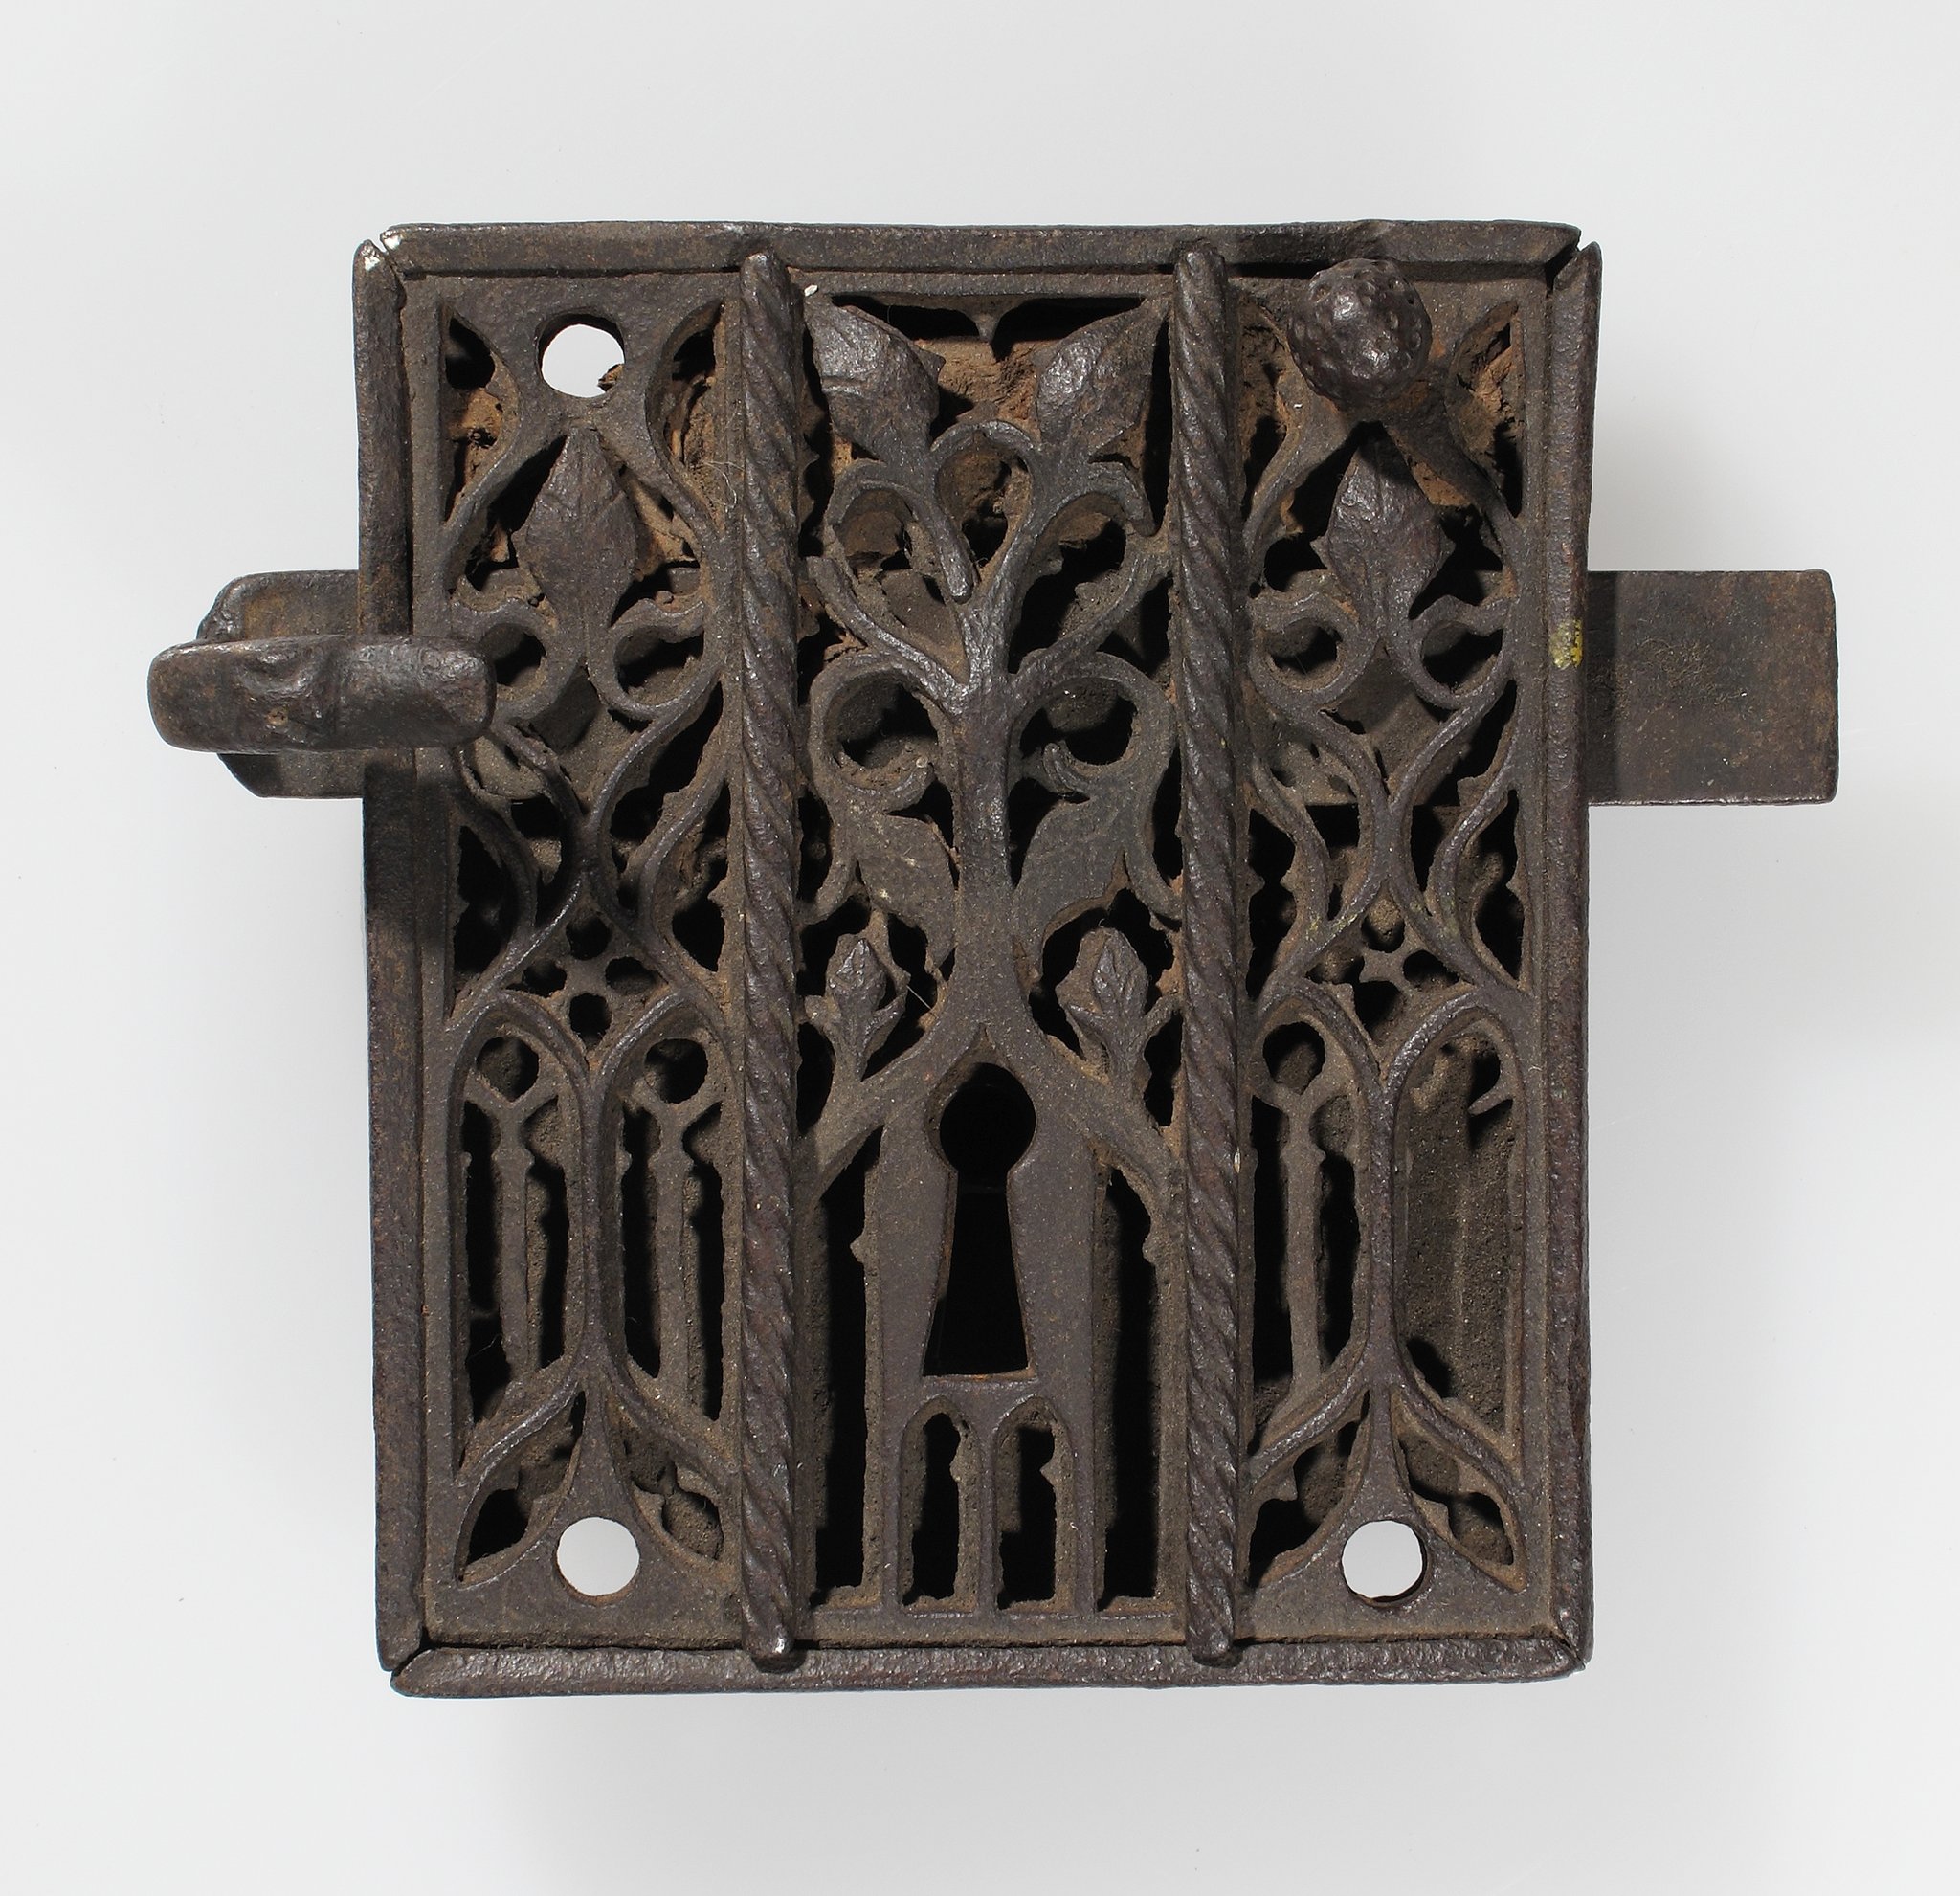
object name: lock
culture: european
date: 1401-1600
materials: iron